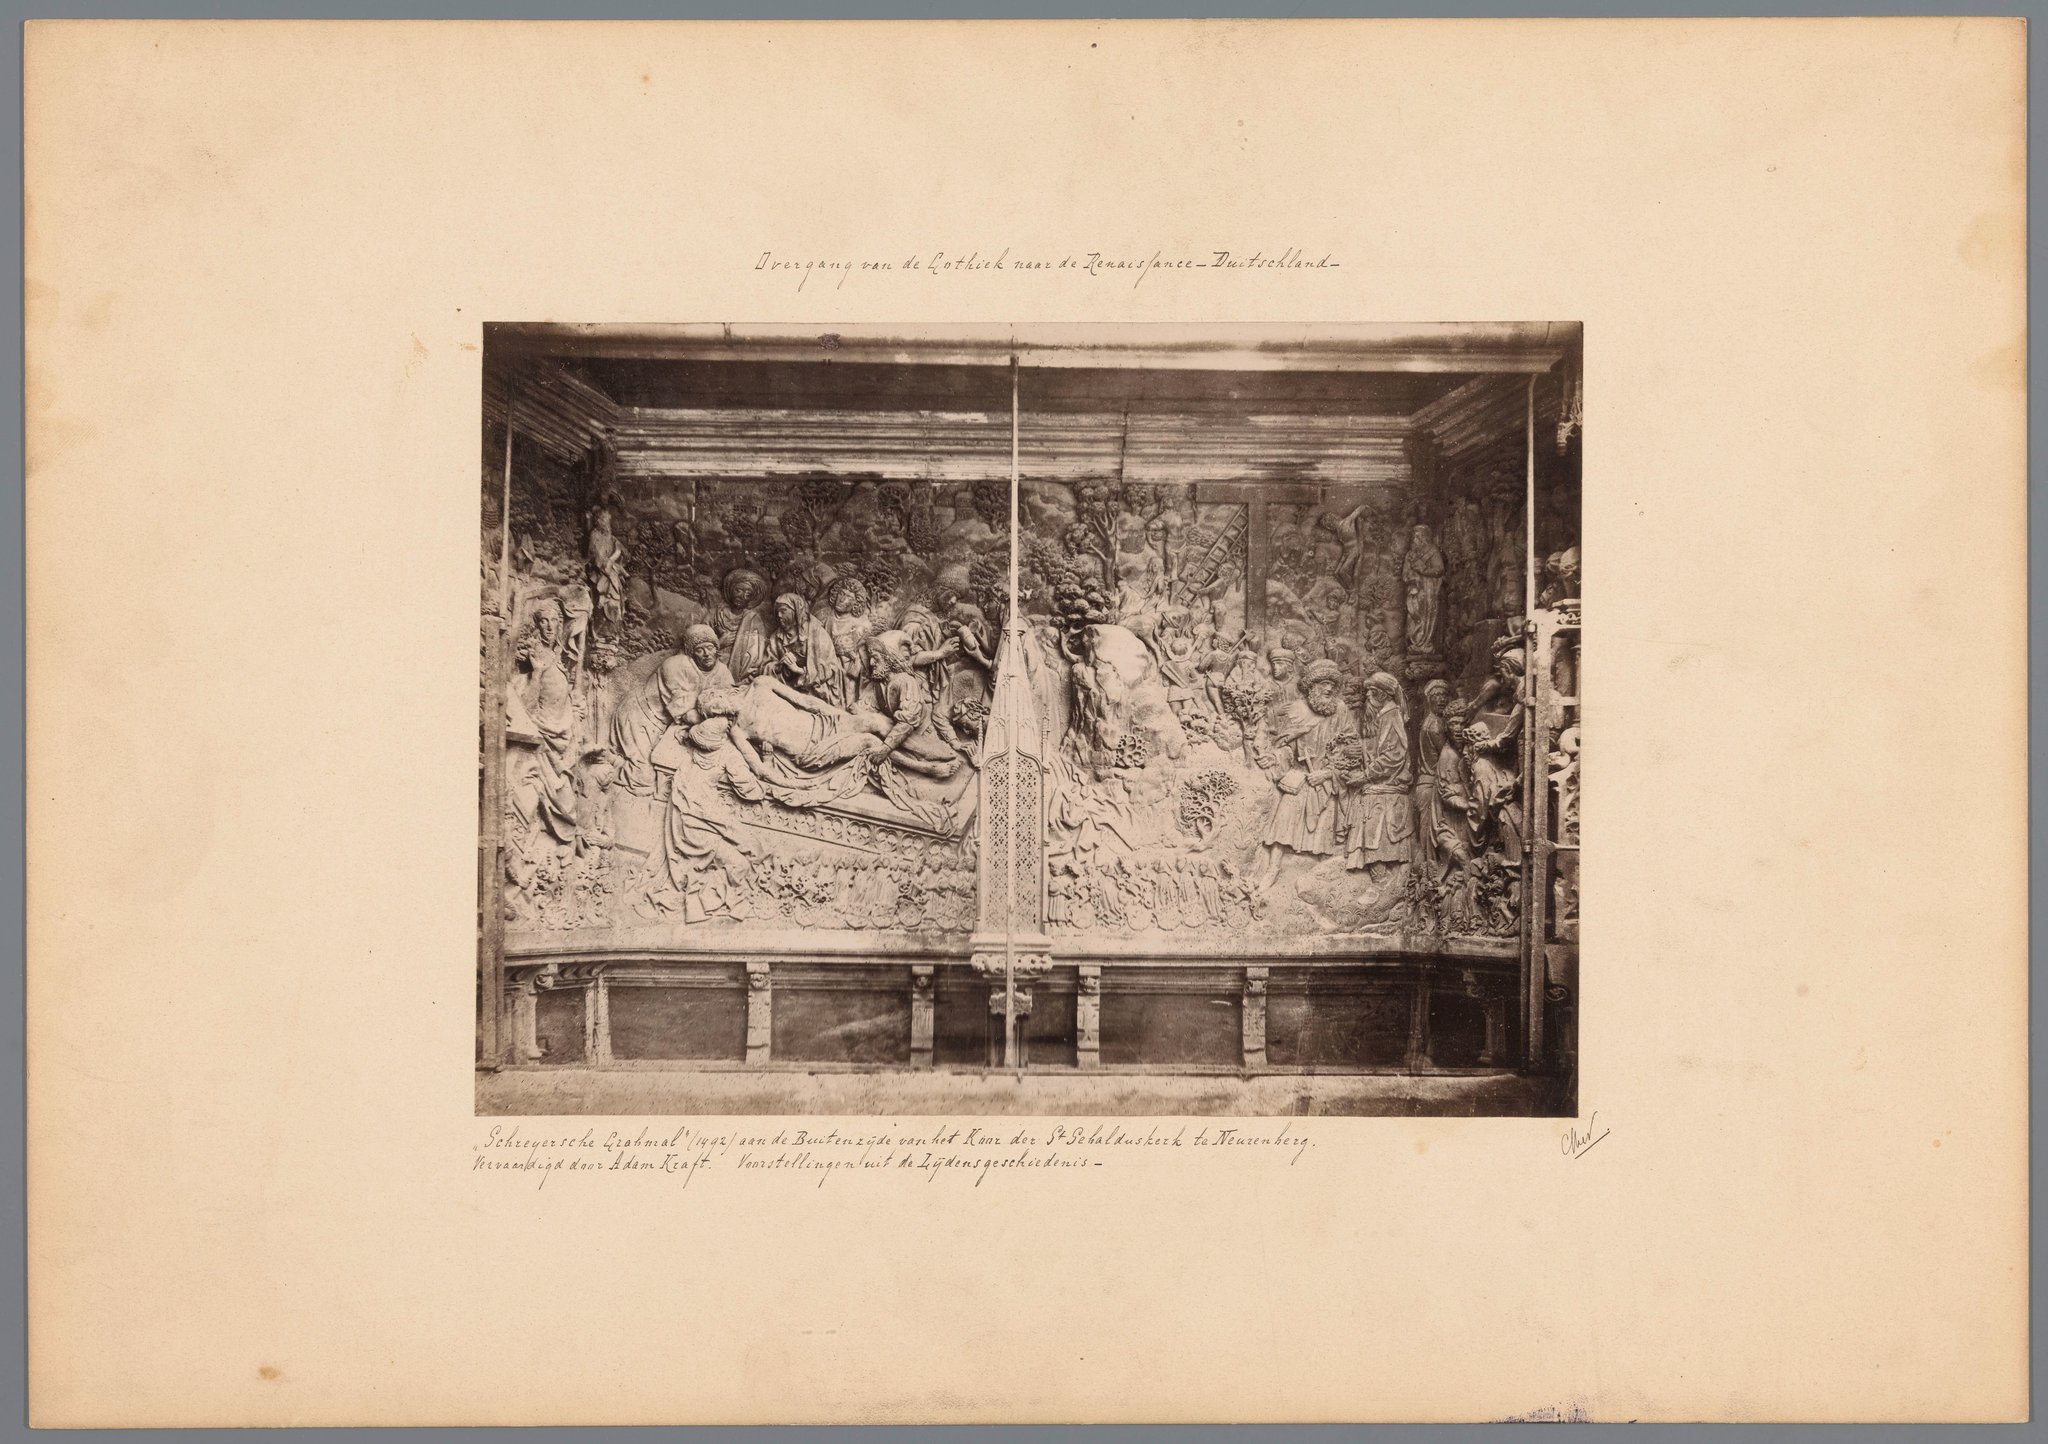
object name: photograph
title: Schreyersche Grabmal aan de buitenzijde van het koor van de Sint-Sebalduskerk te Neurenberg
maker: Anonymous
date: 1875-1900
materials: cardboard, photographic support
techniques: albumen print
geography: nuremberg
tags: descent from the cross: christ is taken down from the cross, usually by nicodemus and joseph of arimathaea who are standing on the ladders (both arms of christ detached), sculpture (+ relief ~ sculpture)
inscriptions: collector's mark: ‘INSTITUUT VOOR KUNST-NIJVERHEIDSONDERWIJS GABRIËL METSUSTRAAT No. 16 AMSTERDAM’, inscription: ‘CWN.’, collector's mark: ‘KUNSTNIJVERHEIDSCHOOL QUELLINUS AMSTERDAM FRANS HALSSTRAAT 14.’, inscription: ‘Overgang van de Gothiek naar de Renaissance - Duitschland.’